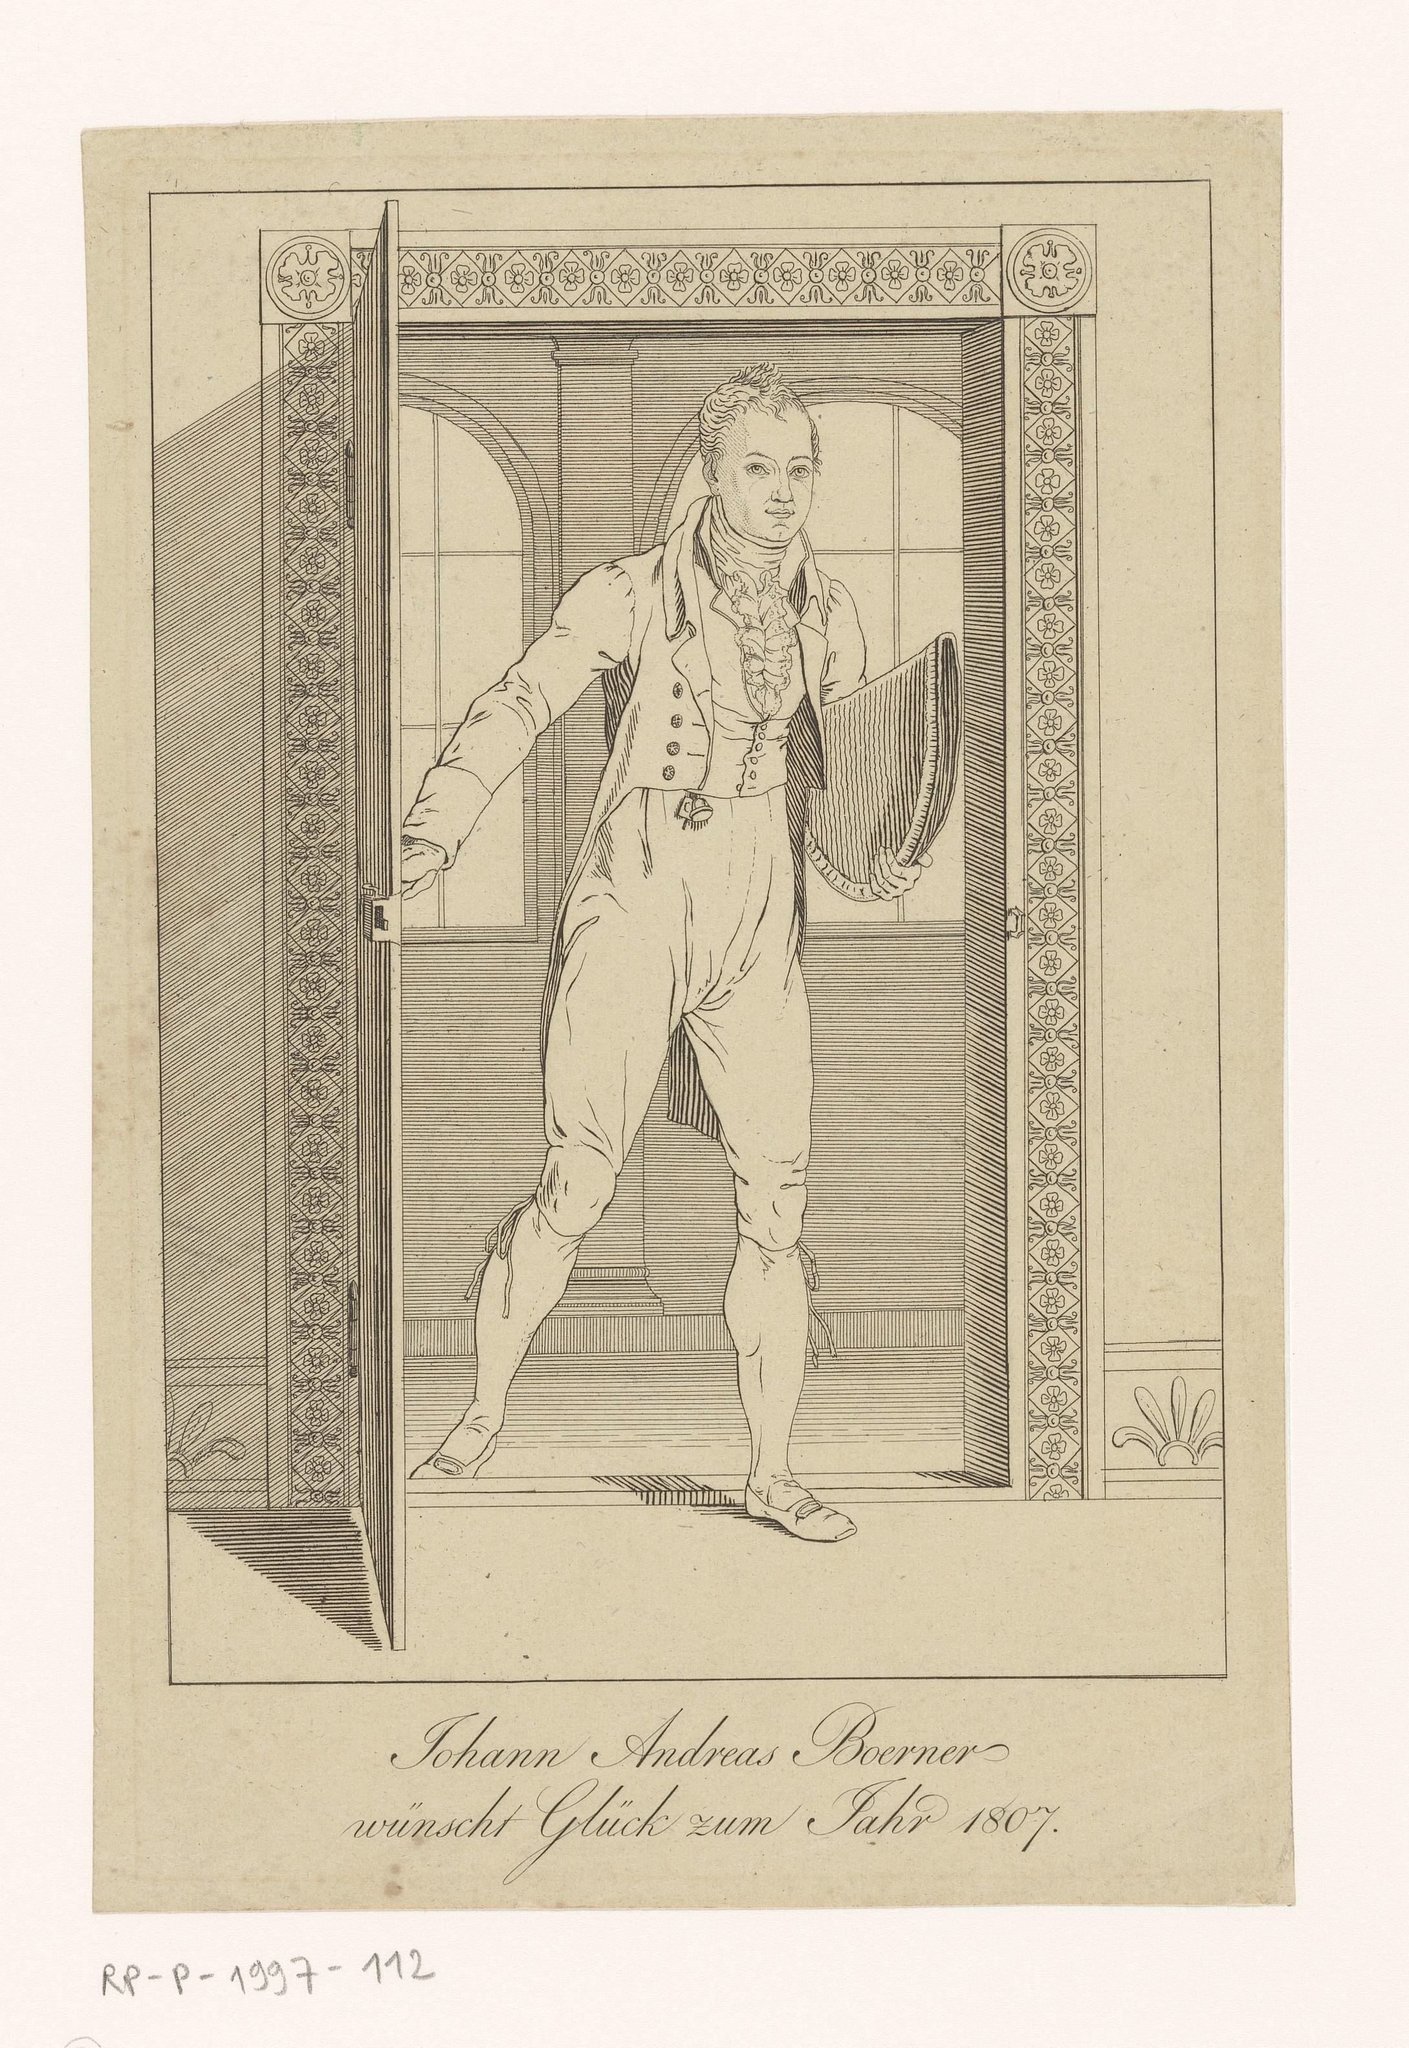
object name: print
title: Johann Andreas Boerner wünscht Glück zum Jahr 1807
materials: paper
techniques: etching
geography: nuremberg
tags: auctioneer, johann andreas boerner, historical persons, art dealer, portrait, self-portrait of graphic artist